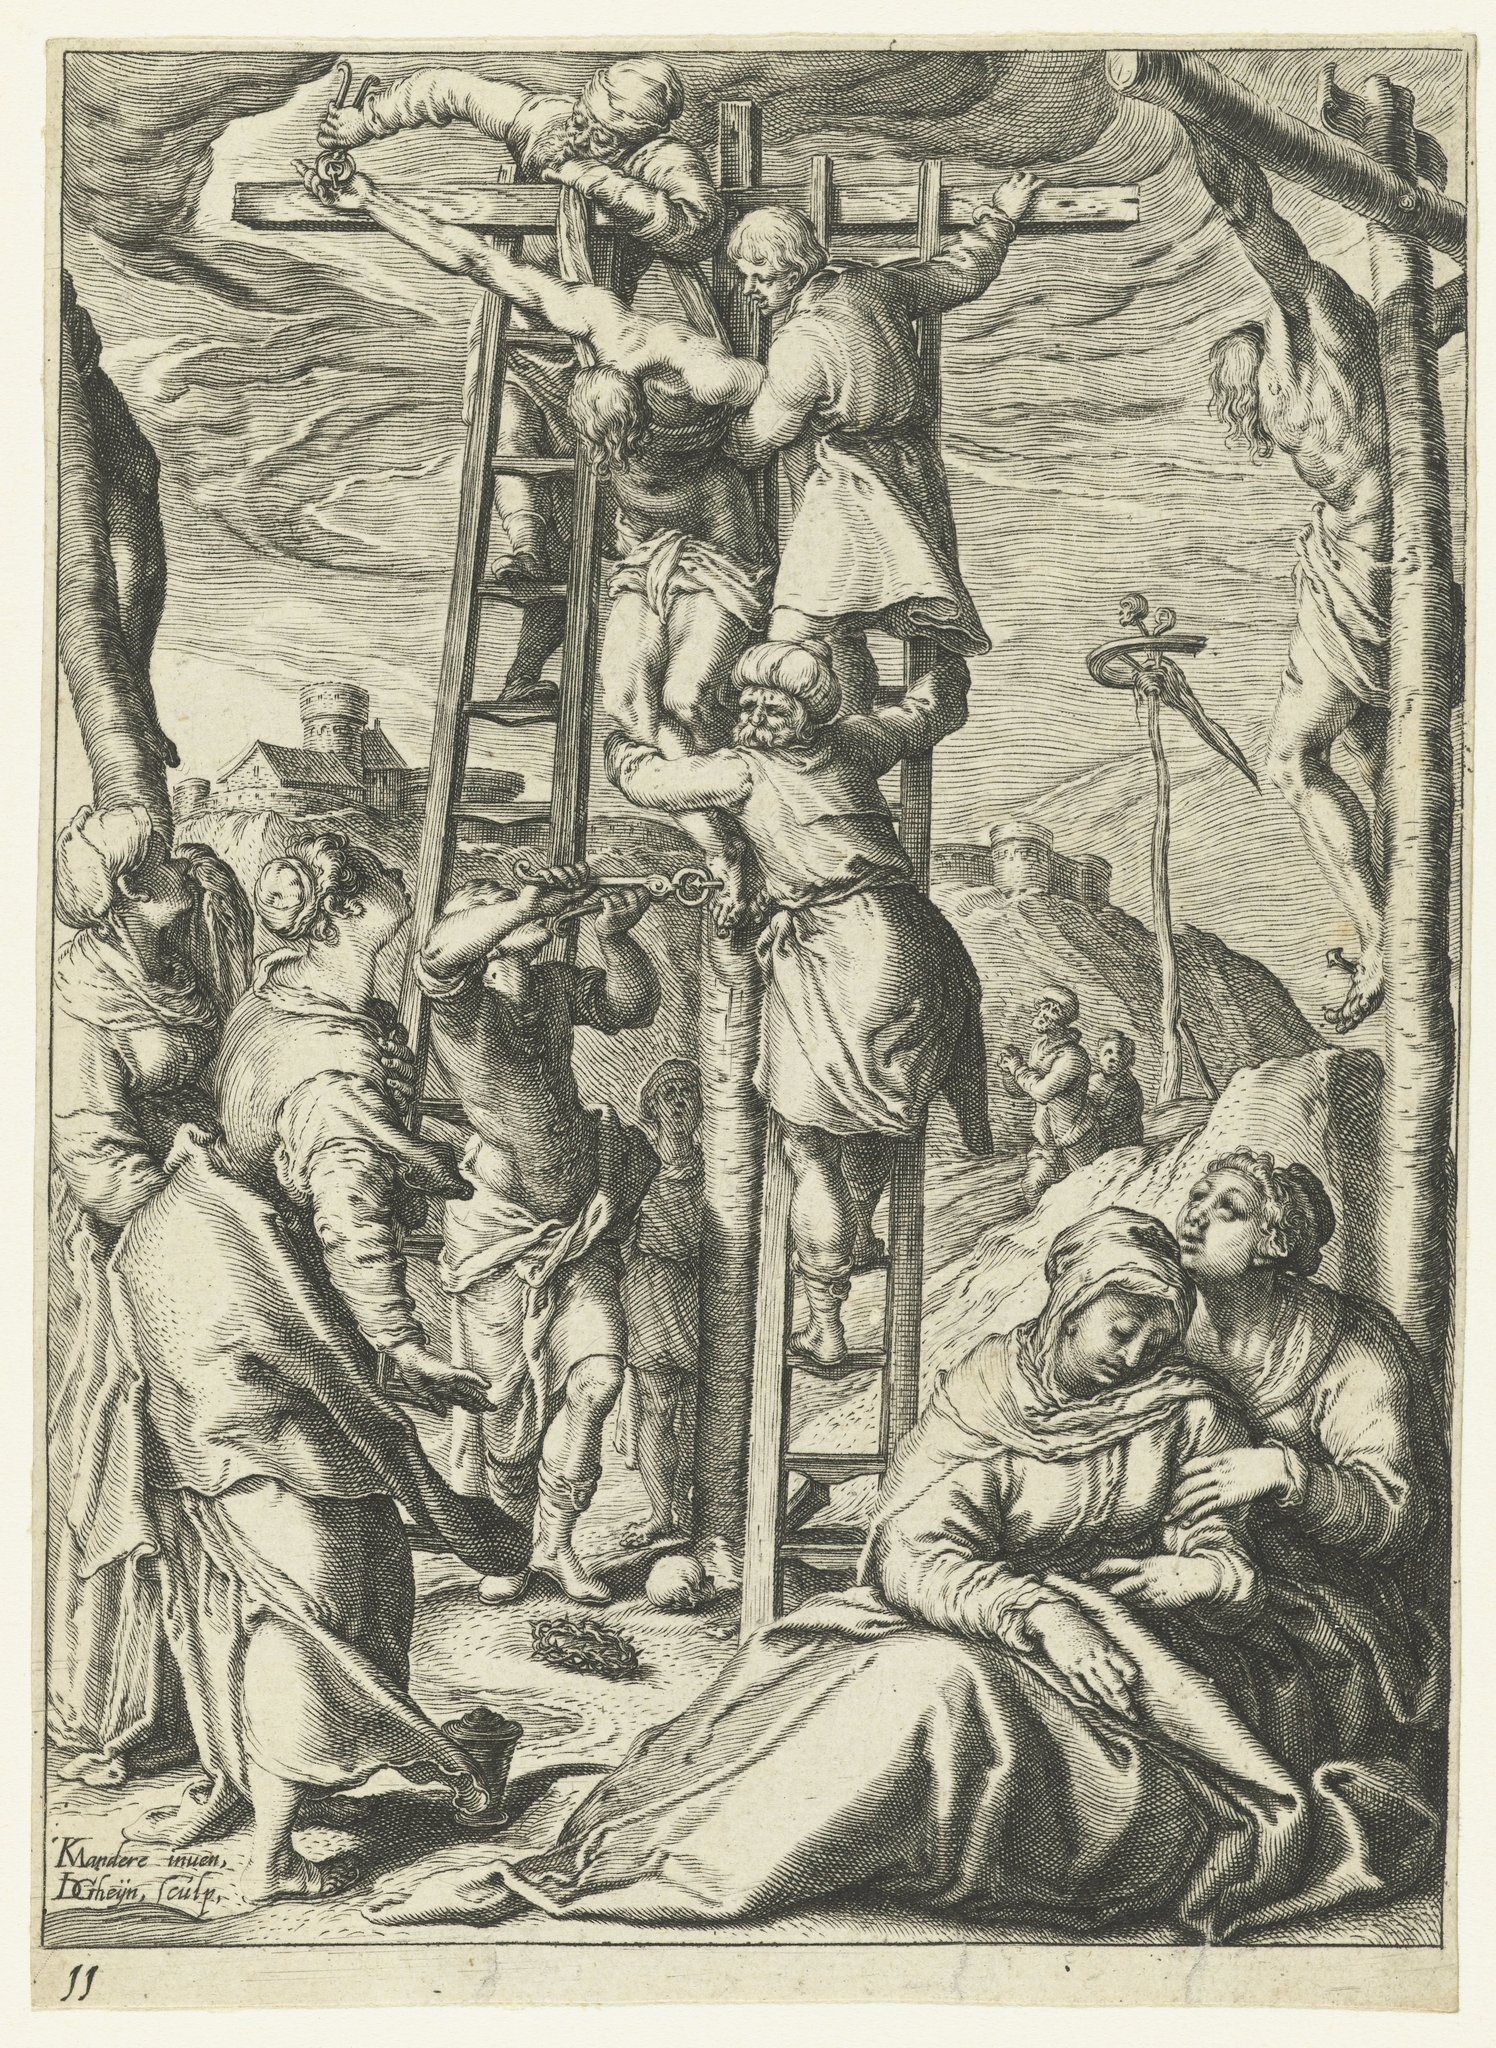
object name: print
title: De kruisafname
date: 1596-1598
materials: paper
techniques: engraving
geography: leiden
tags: christ is taken down from the cross (one arm of christ still nailed to the cross)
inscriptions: collector's mark: Lugt 240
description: Christus wordt door vier mannen van het kruis gehaald. Op de voorgrond staan twee vrouwen toe te kijken, een derde zit er treurend bij, getroost door een vierde. Deze prent is onderdeel van een serie voorstellingen van het Lijdensverhaal.